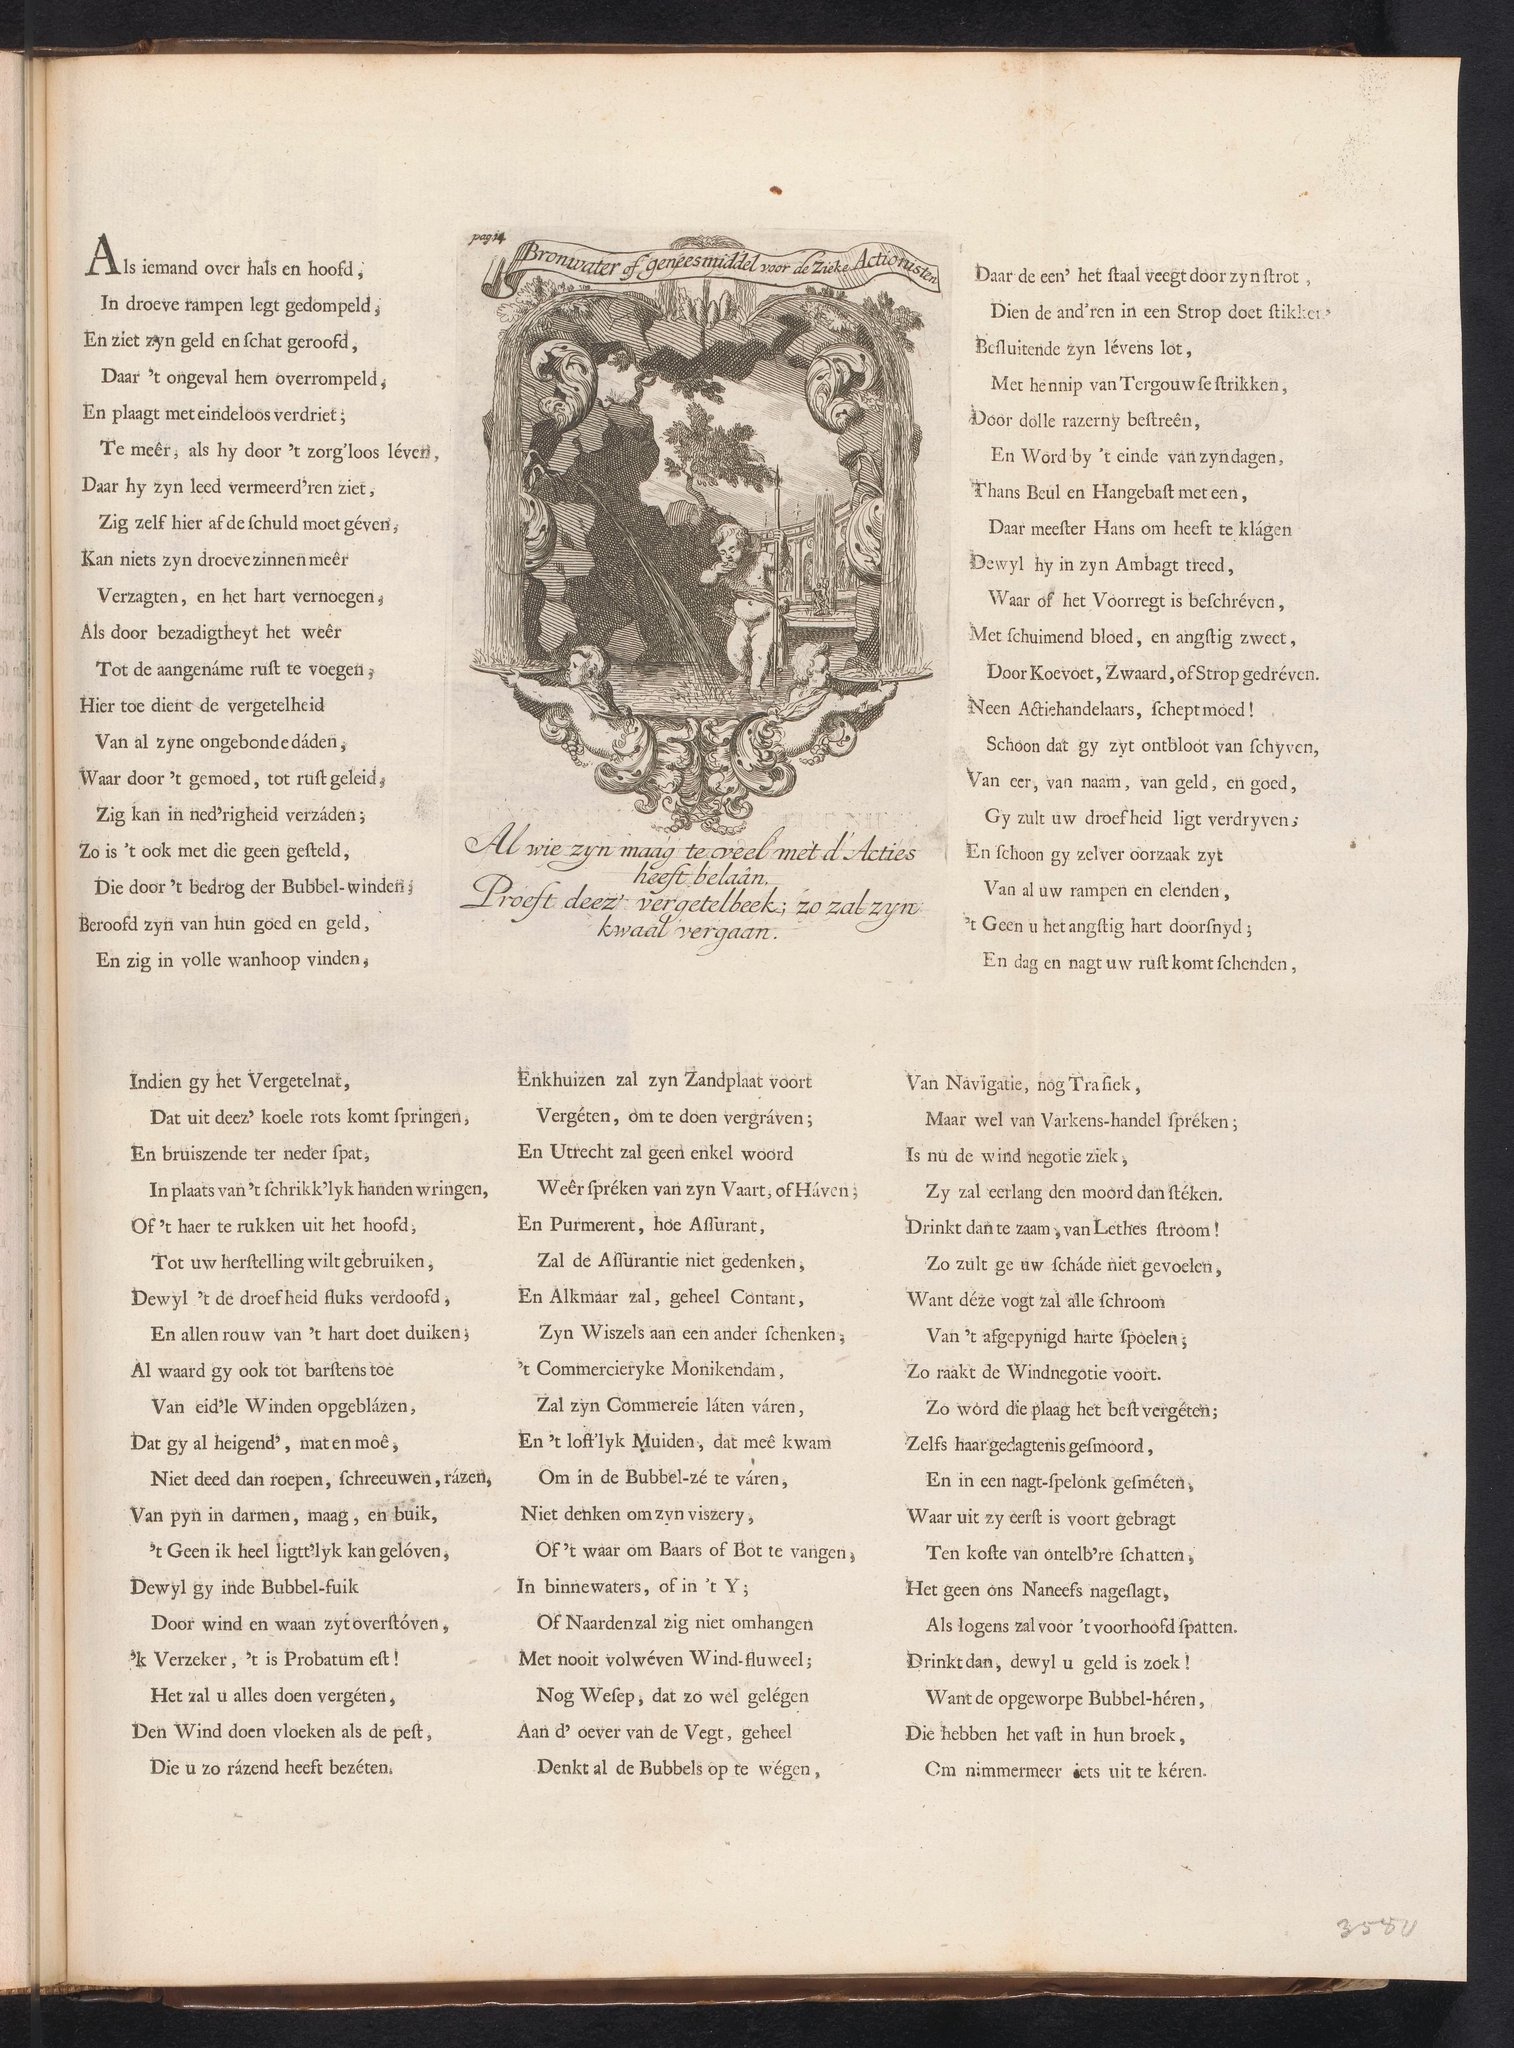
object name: print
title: Bronwater als geneesmiddel voor de zieke Actionisten, 1720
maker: pieter van den berge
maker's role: draughtsman, print maker, printer, publisher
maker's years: 1659-1737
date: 1697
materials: paper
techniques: engraving, etching, letterpress printing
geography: northern netherlands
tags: medicinal spring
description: Bronwater als geneesmiddel voor de zieke Actionisten. Een jongetje, een slachtoffer van de windhandel, drinkt van het water uit de bron der vergetelheid. In een decoratieve omlijsting met watervallen. Gemerkt linksboven: pag. 14. In het onderschrift een vers van vier regels. Gedrukt op het blad om en onder de plaat staan vijf verzen. Prent in de gebonden eerste uitgave (304 B 11) van Het Groote Tafereel der Dwaasheid met spotprenten op de Windhandel of Actiehandel van 1720.